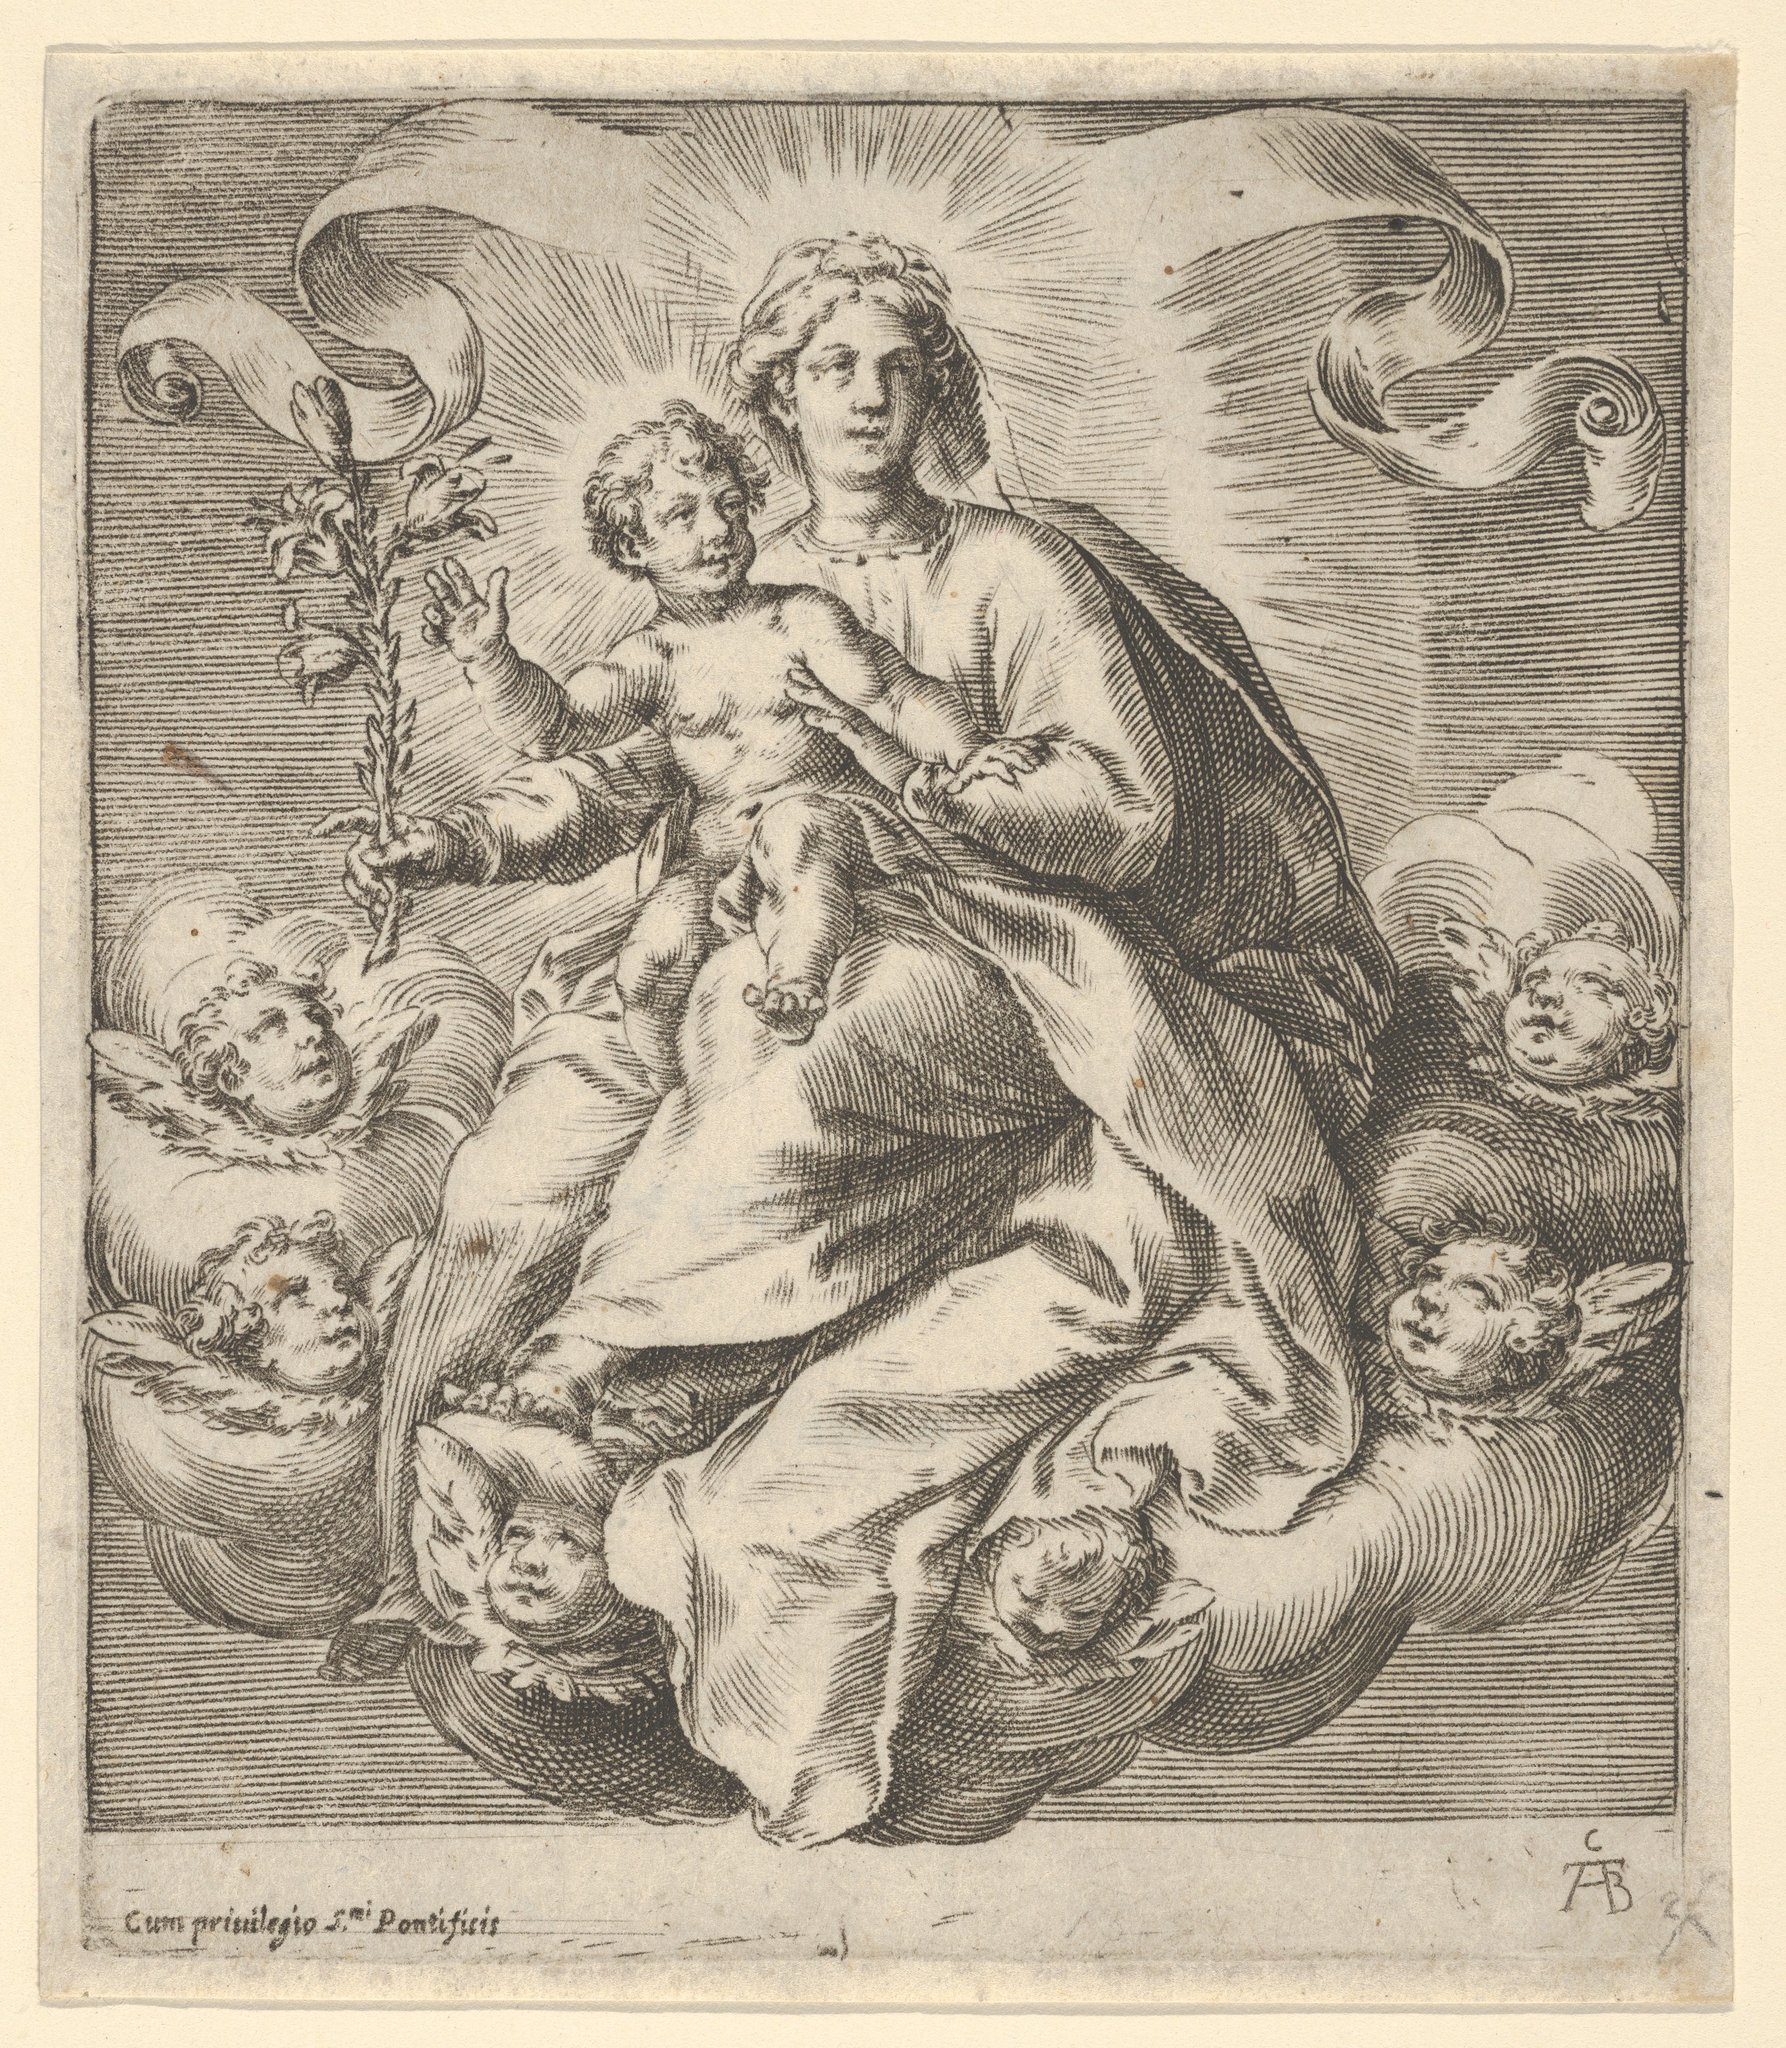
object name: print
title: Madonna holding a lily branch with the Christ Child on her lap, seated on clouds, surrounded by cherub heads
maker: cherubino alberti (zaccaria mattia)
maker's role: artist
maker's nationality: italian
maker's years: 1553-1615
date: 1570-1615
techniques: engraving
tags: madonna and child